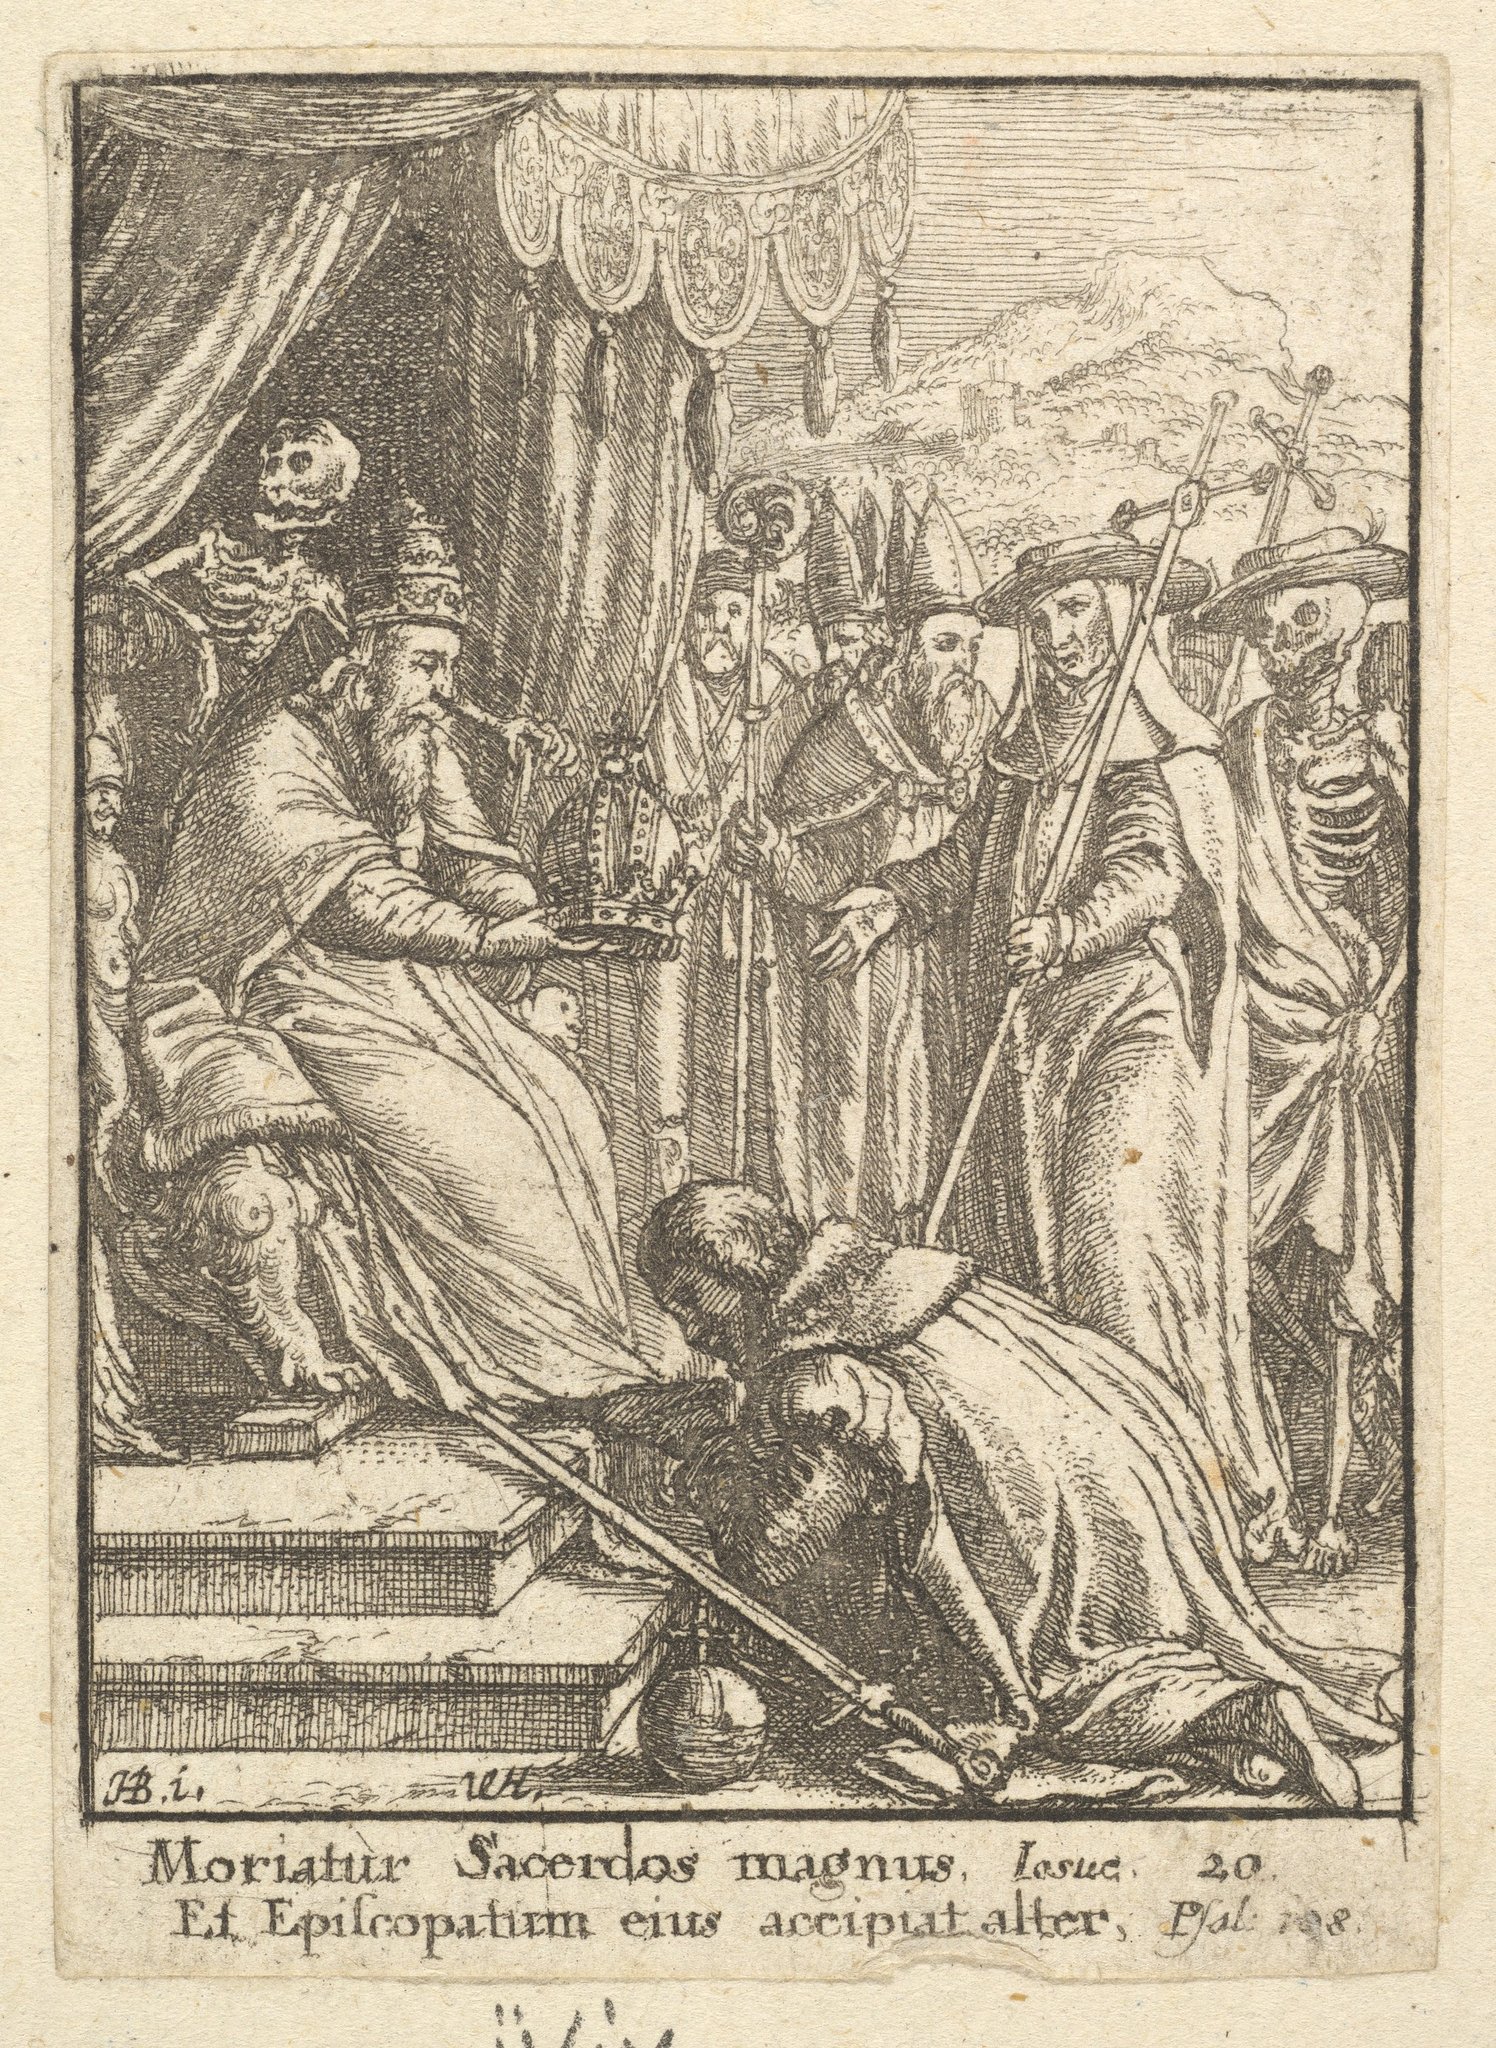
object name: print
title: The Pope, from the Dance of Death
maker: wenceslaus hollar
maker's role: artist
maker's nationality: bohemian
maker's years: 1607-1677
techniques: etching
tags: swords,skeletons,popes,death